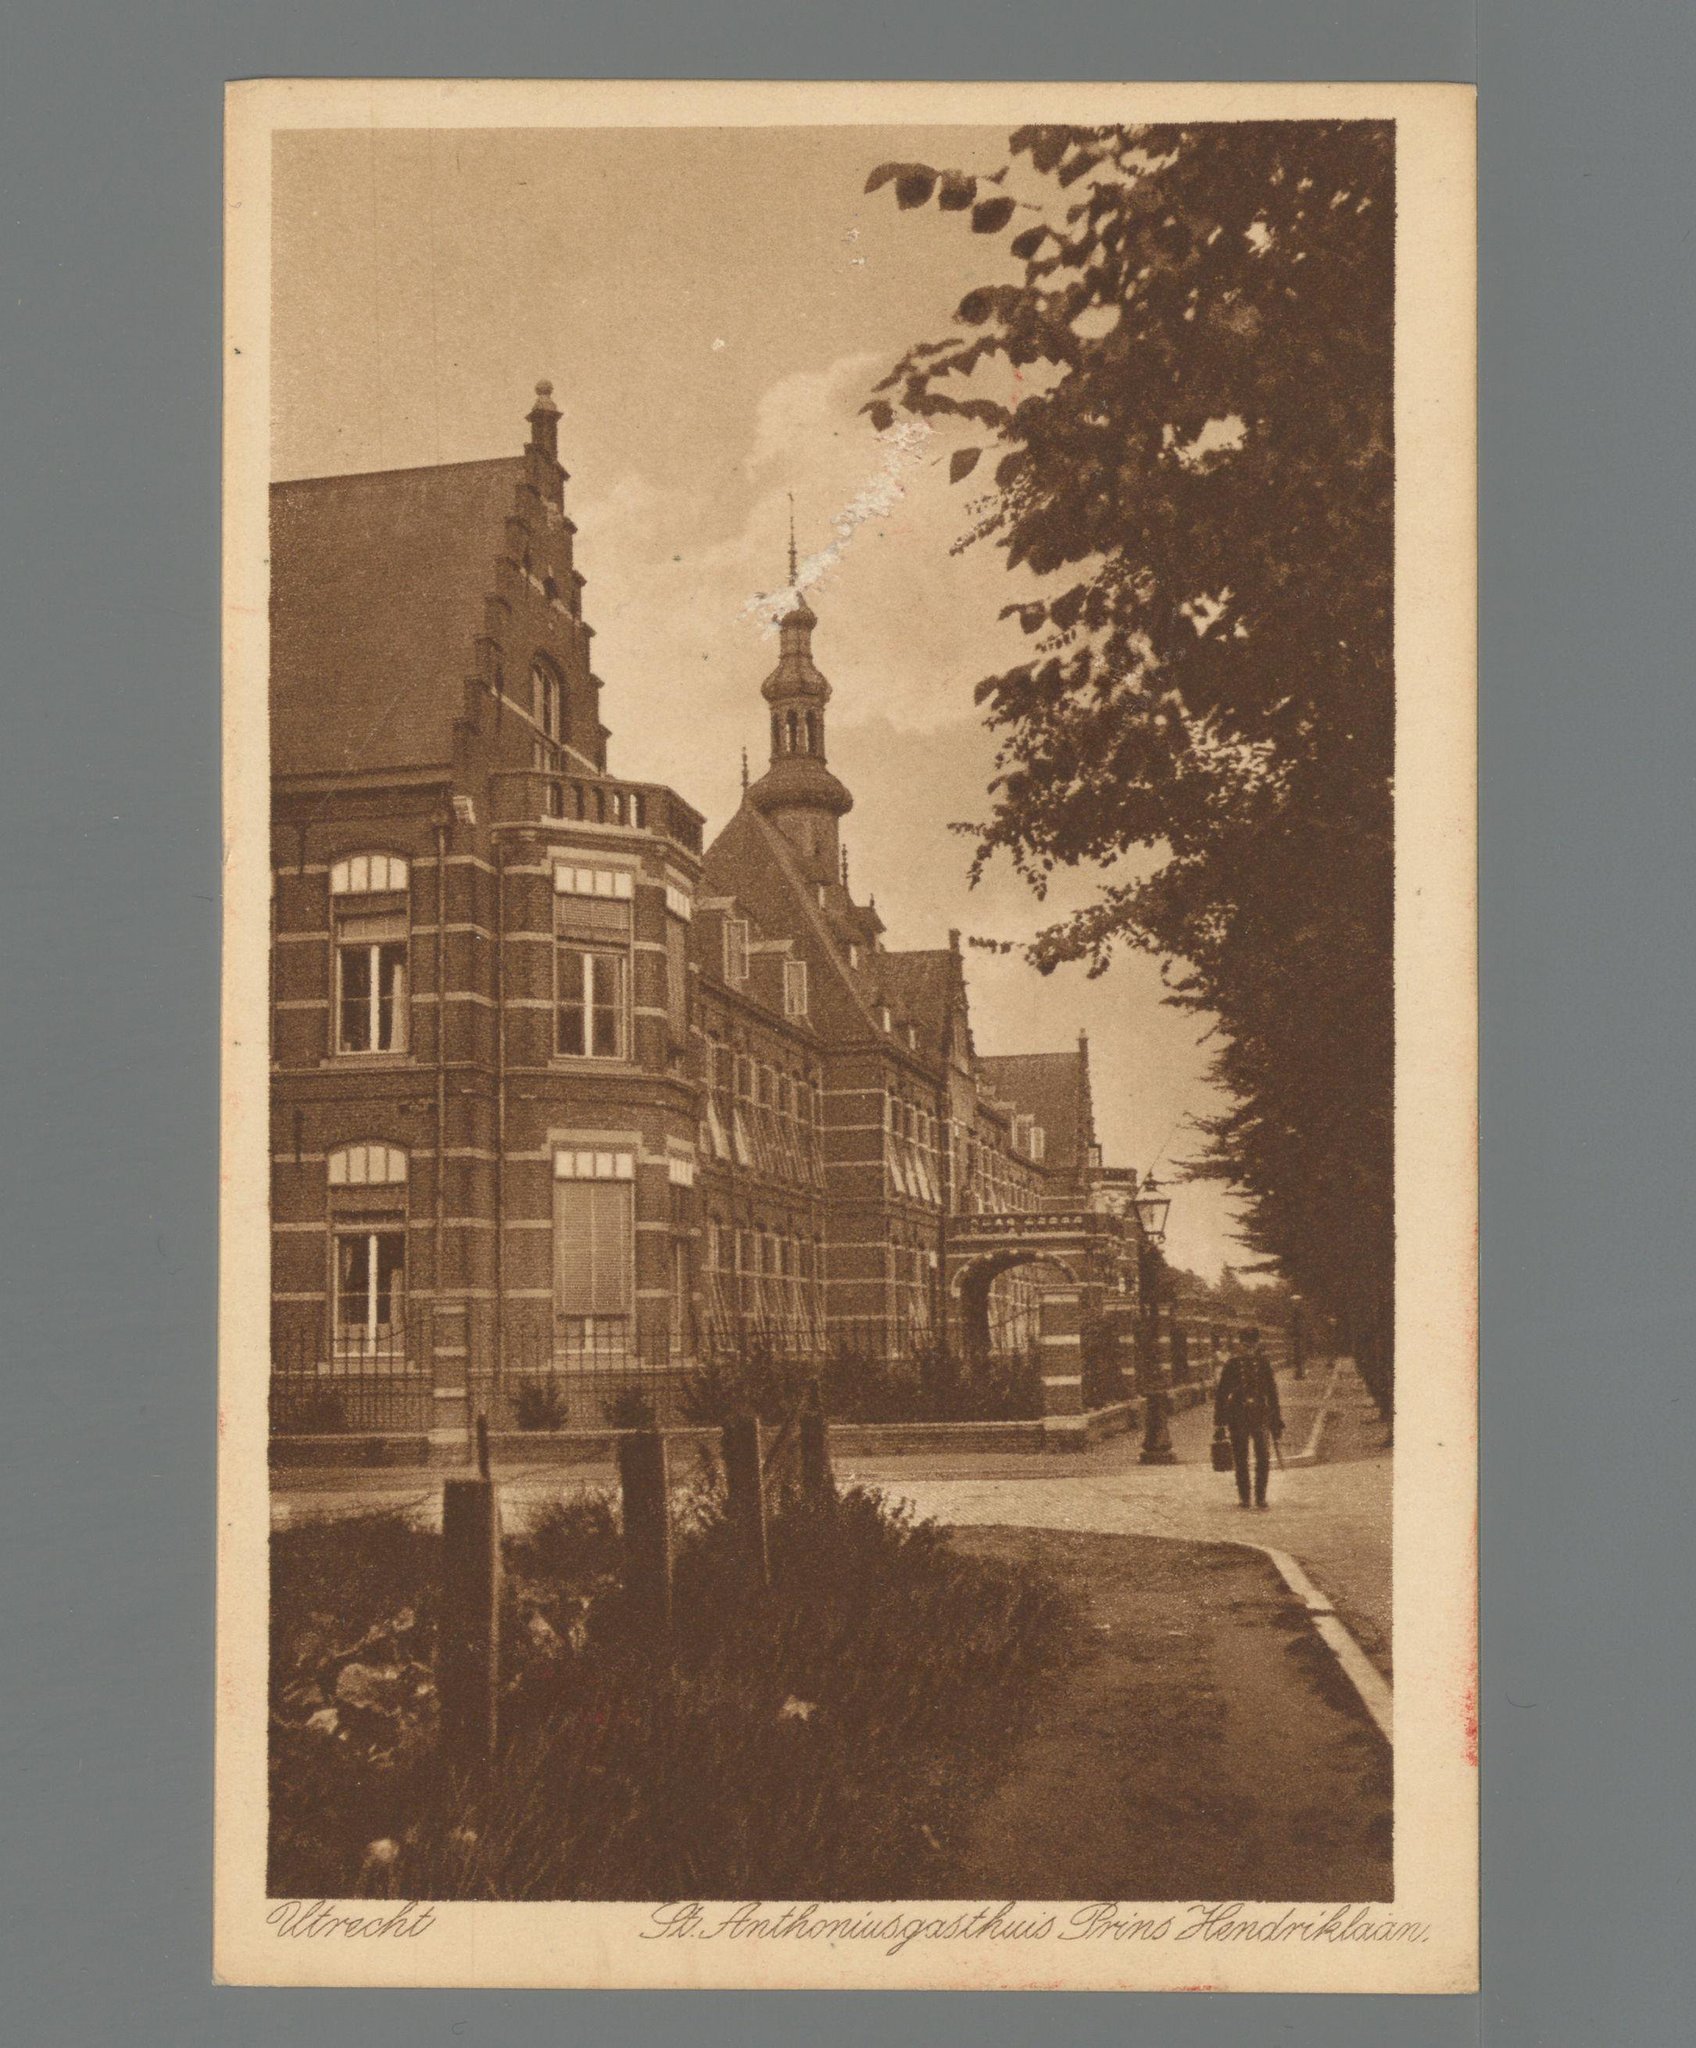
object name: photomechanical print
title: J.H. Schaefer's Kopertiefdruk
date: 1913-1926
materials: cardboard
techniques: rotogravure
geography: utrecht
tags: hospital